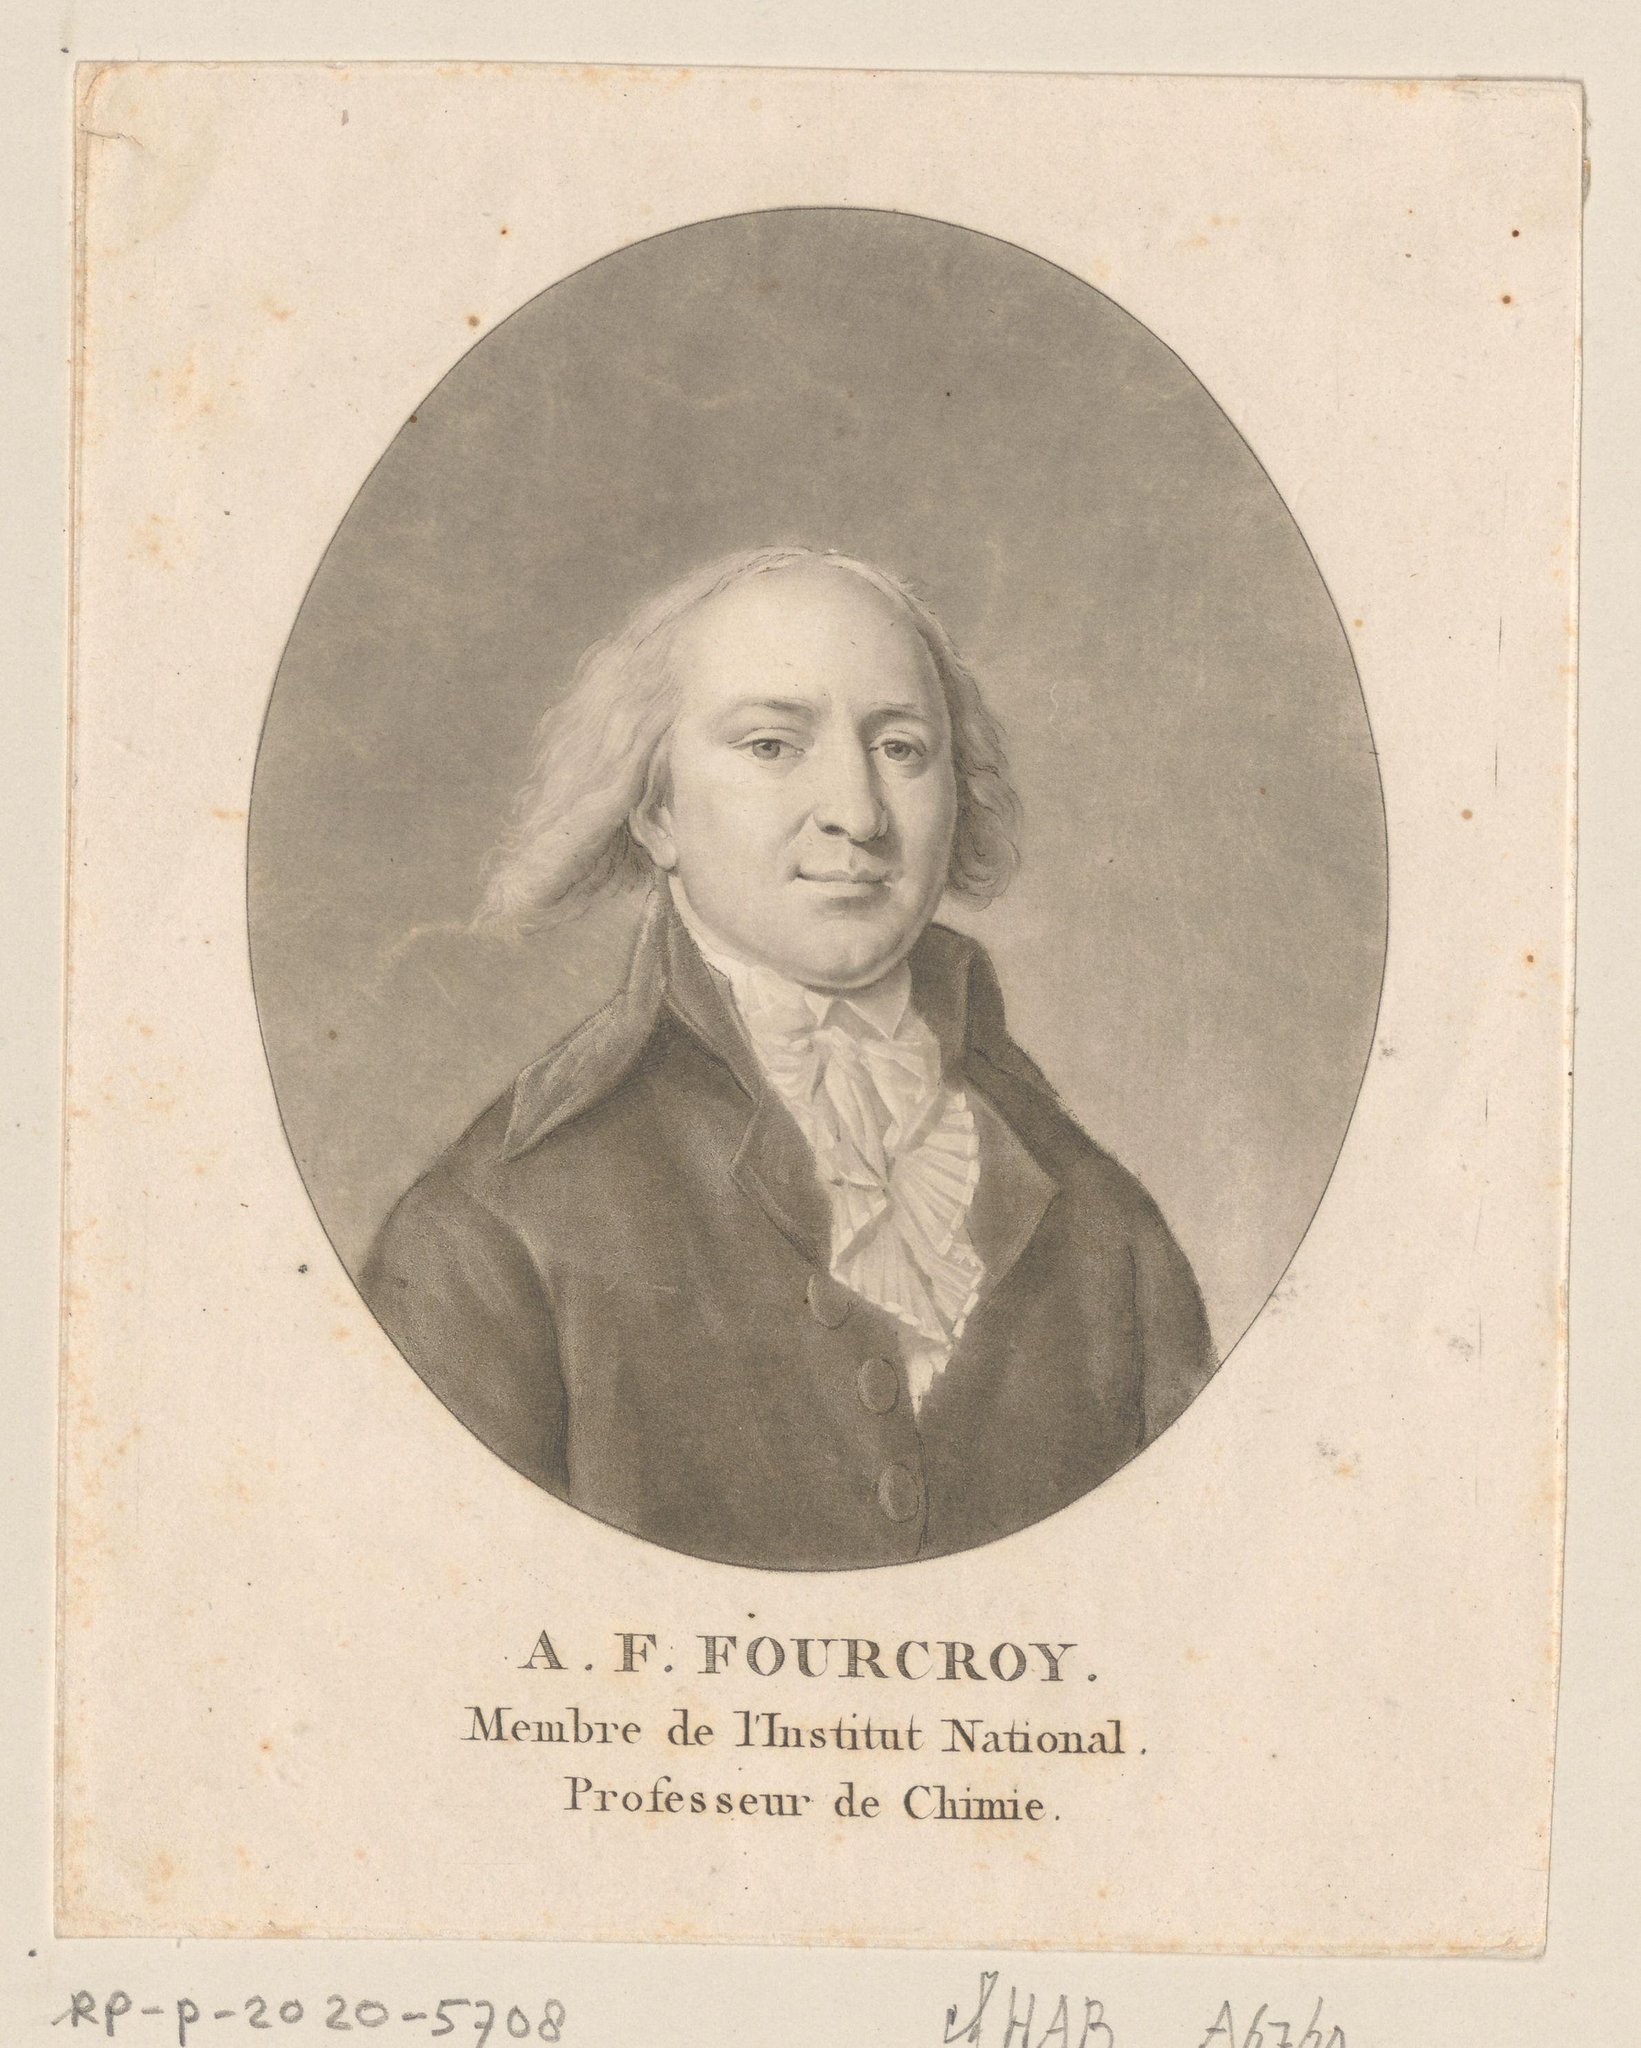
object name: print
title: Portret van Antoine François de Fourcroy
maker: Anonymous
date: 1797-1798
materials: paper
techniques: aquatint, etching, retroussage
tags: paris, politician, chemistry (+ portrait of scholar, scientist), historical persons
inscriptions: collector's mark: Lugt 988b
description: Prent waarschijnlijk uit: Schmeisser, Johann Gottfried. Beyträge zur näheren Kenntniß des gegenwärtigen Zustandes der Wissenschaften in Frankreich. Hamburg: Benjamin Gottlob Hoffmann, 1797, dl. 1. Of uit deel 2, uitgegeven in 1798.